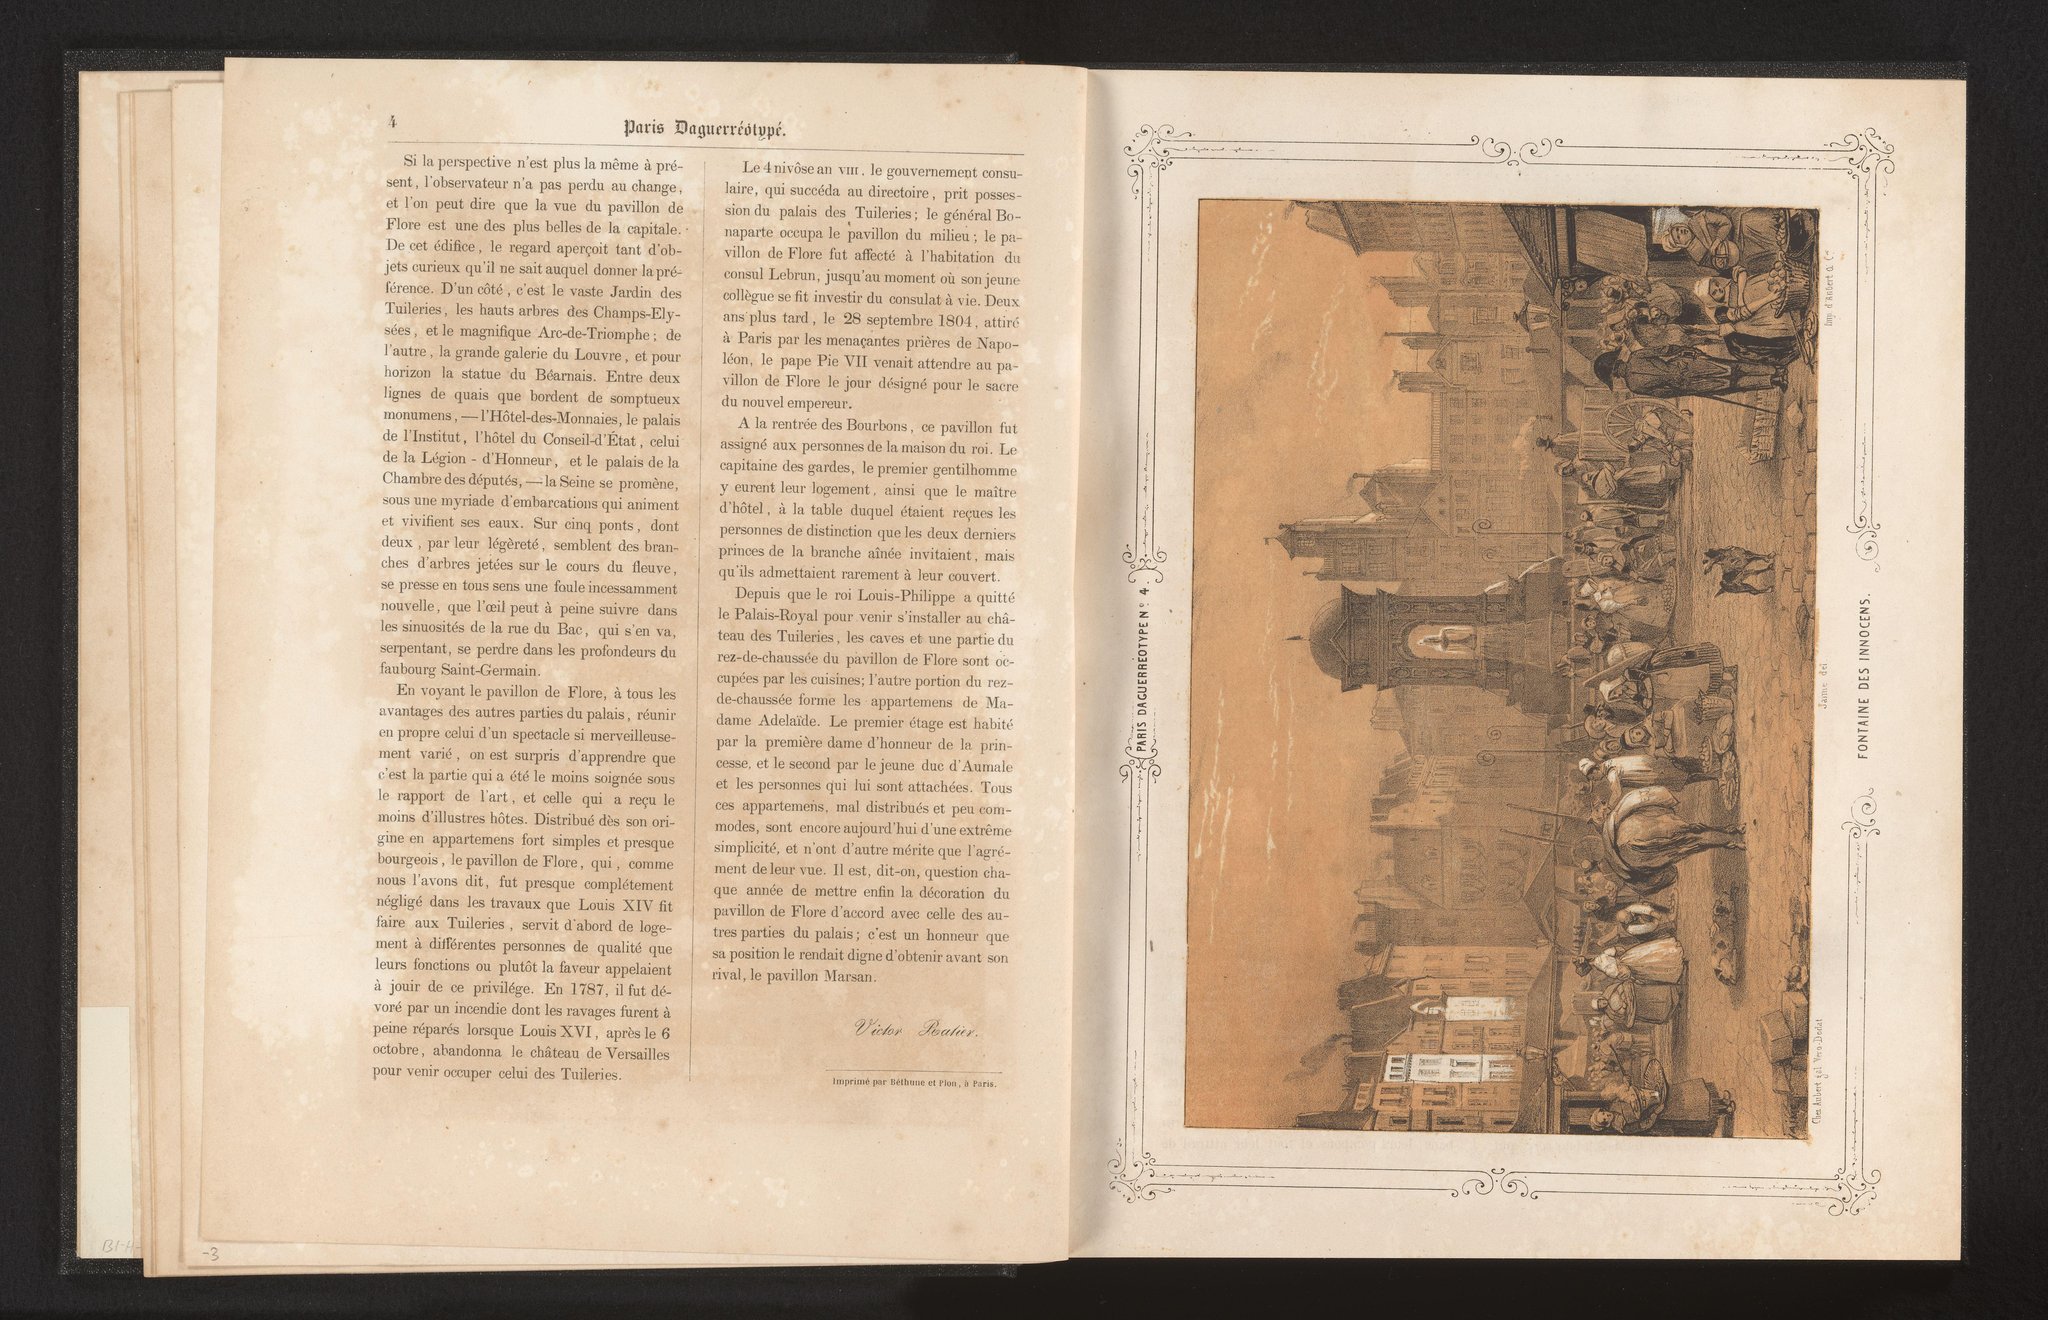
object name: print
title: Fontaine des Innocents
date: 1839-1840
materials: paper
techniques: tone lithography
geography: paris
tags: square, place, circus, etc., ornamental fountain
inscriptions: inscription: ‘PARIS DAGUERRÉOTYPÉ No. 4.’